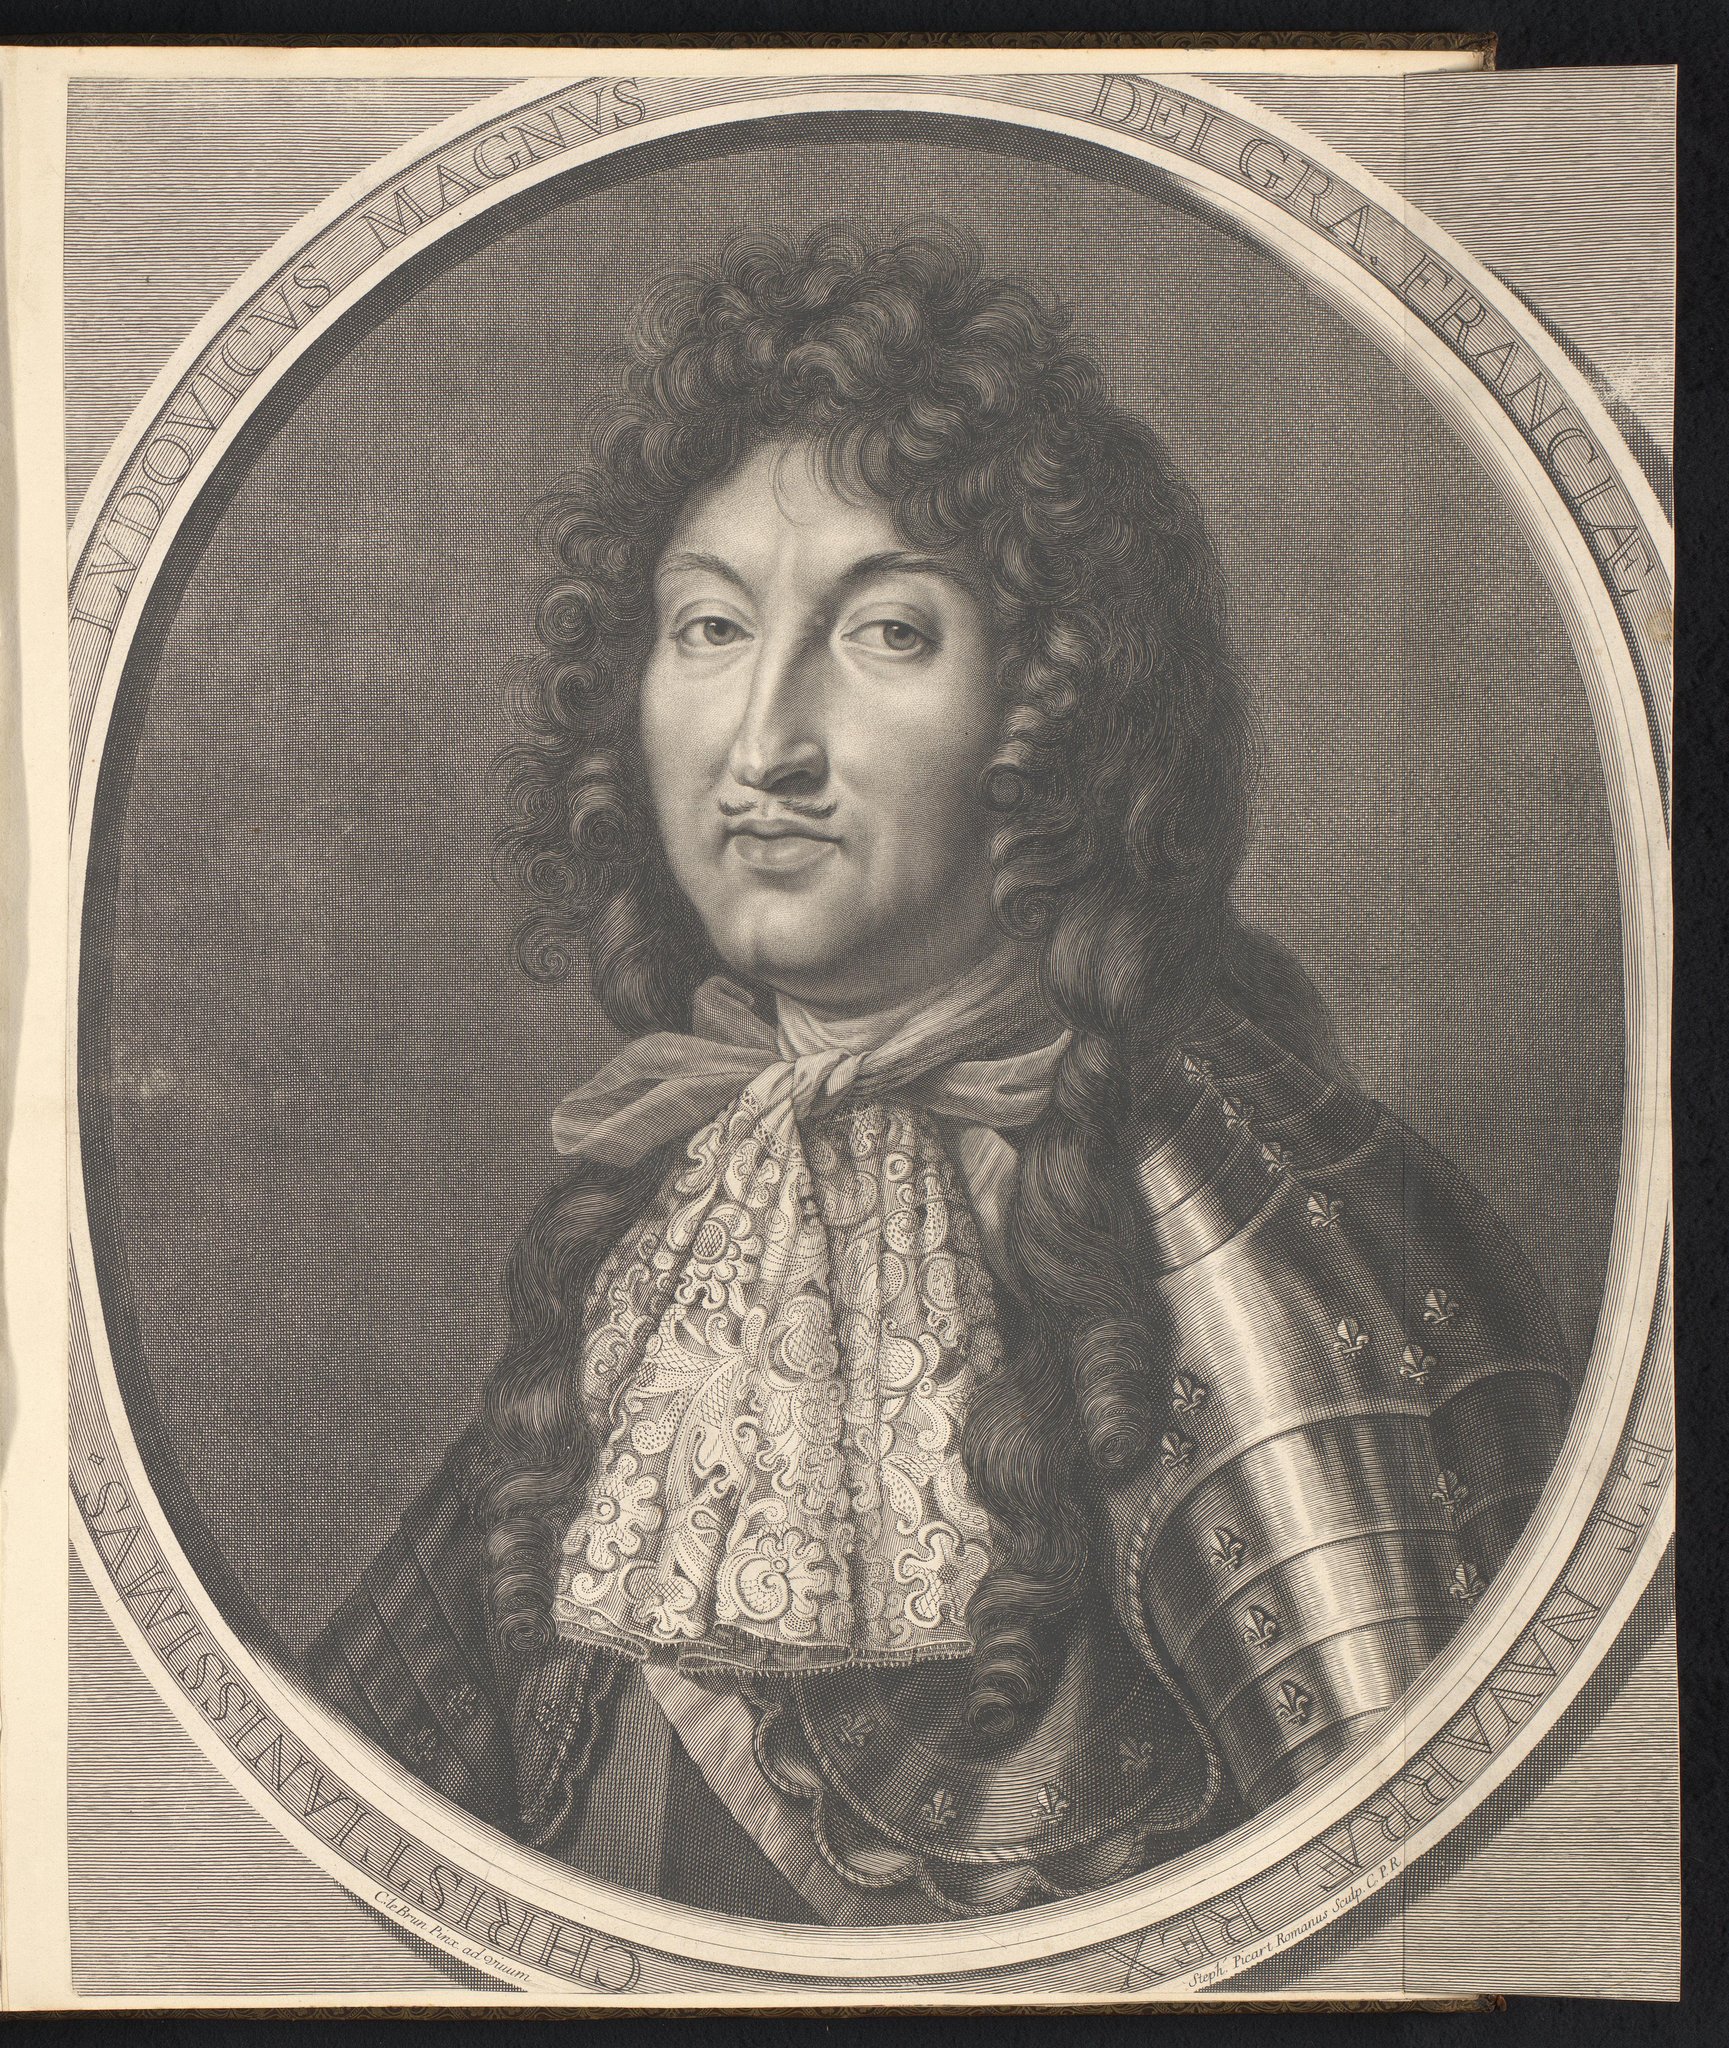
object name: print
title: Portret van Lodewijk XIV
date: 1642-1721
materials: paper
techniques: engraving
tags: lodewijk xiv (koning van frankrijk), historical persons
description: Deze prent maakt deel uit van een album.